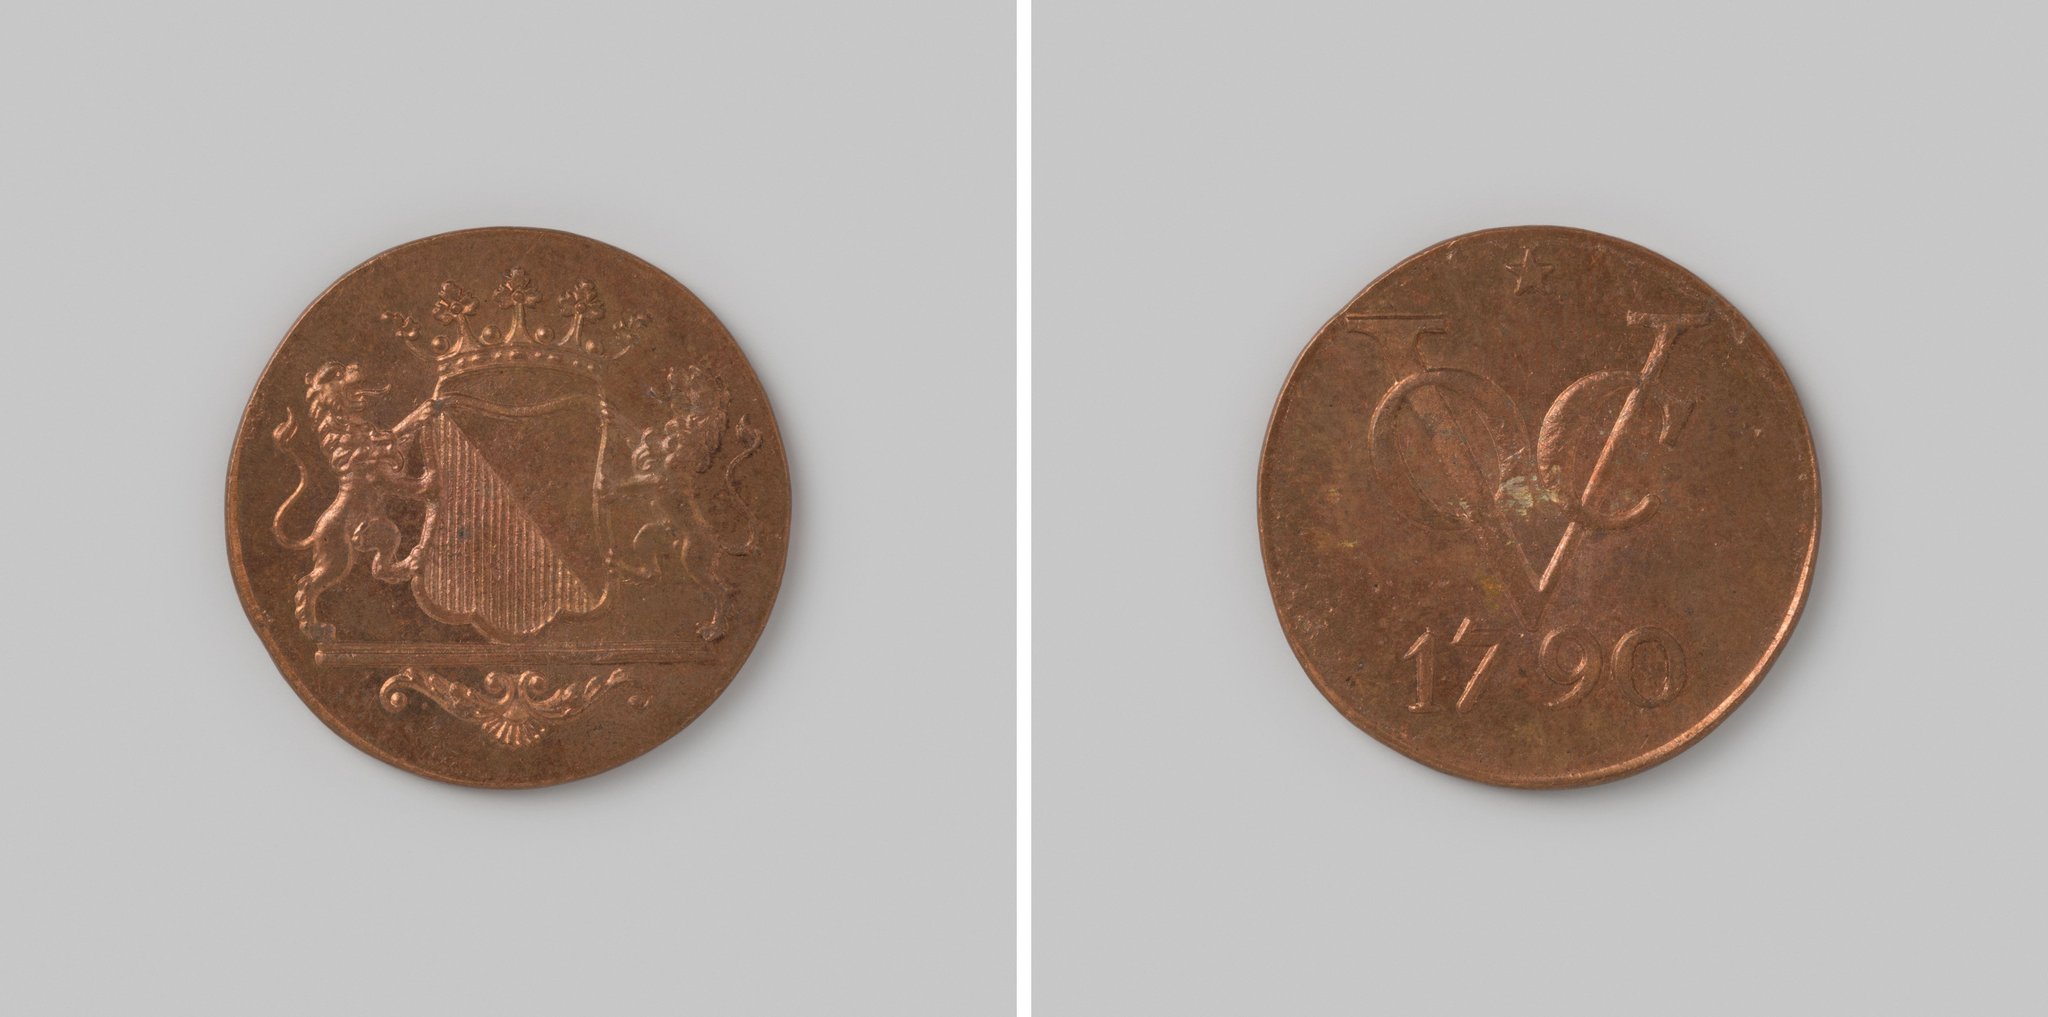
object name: coin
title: Dubbele duit op naam van de VOC en de stad Utrecht met jaartal1790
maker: william ii of the netherlands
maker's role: koning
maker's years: 1792-1849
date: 1840-1843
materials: copper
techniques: striking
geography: surabaya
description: Koperen munt. Voorzijde: op balk, waaronder guirlande, staand, door twee leeuwen gehouden gekroond wapenschild van de stad Utrecht. Keerzijde: monogram van de VOC, waarboven muntteken ster en waaronder fictief jaartal 1790. Gladde rand.